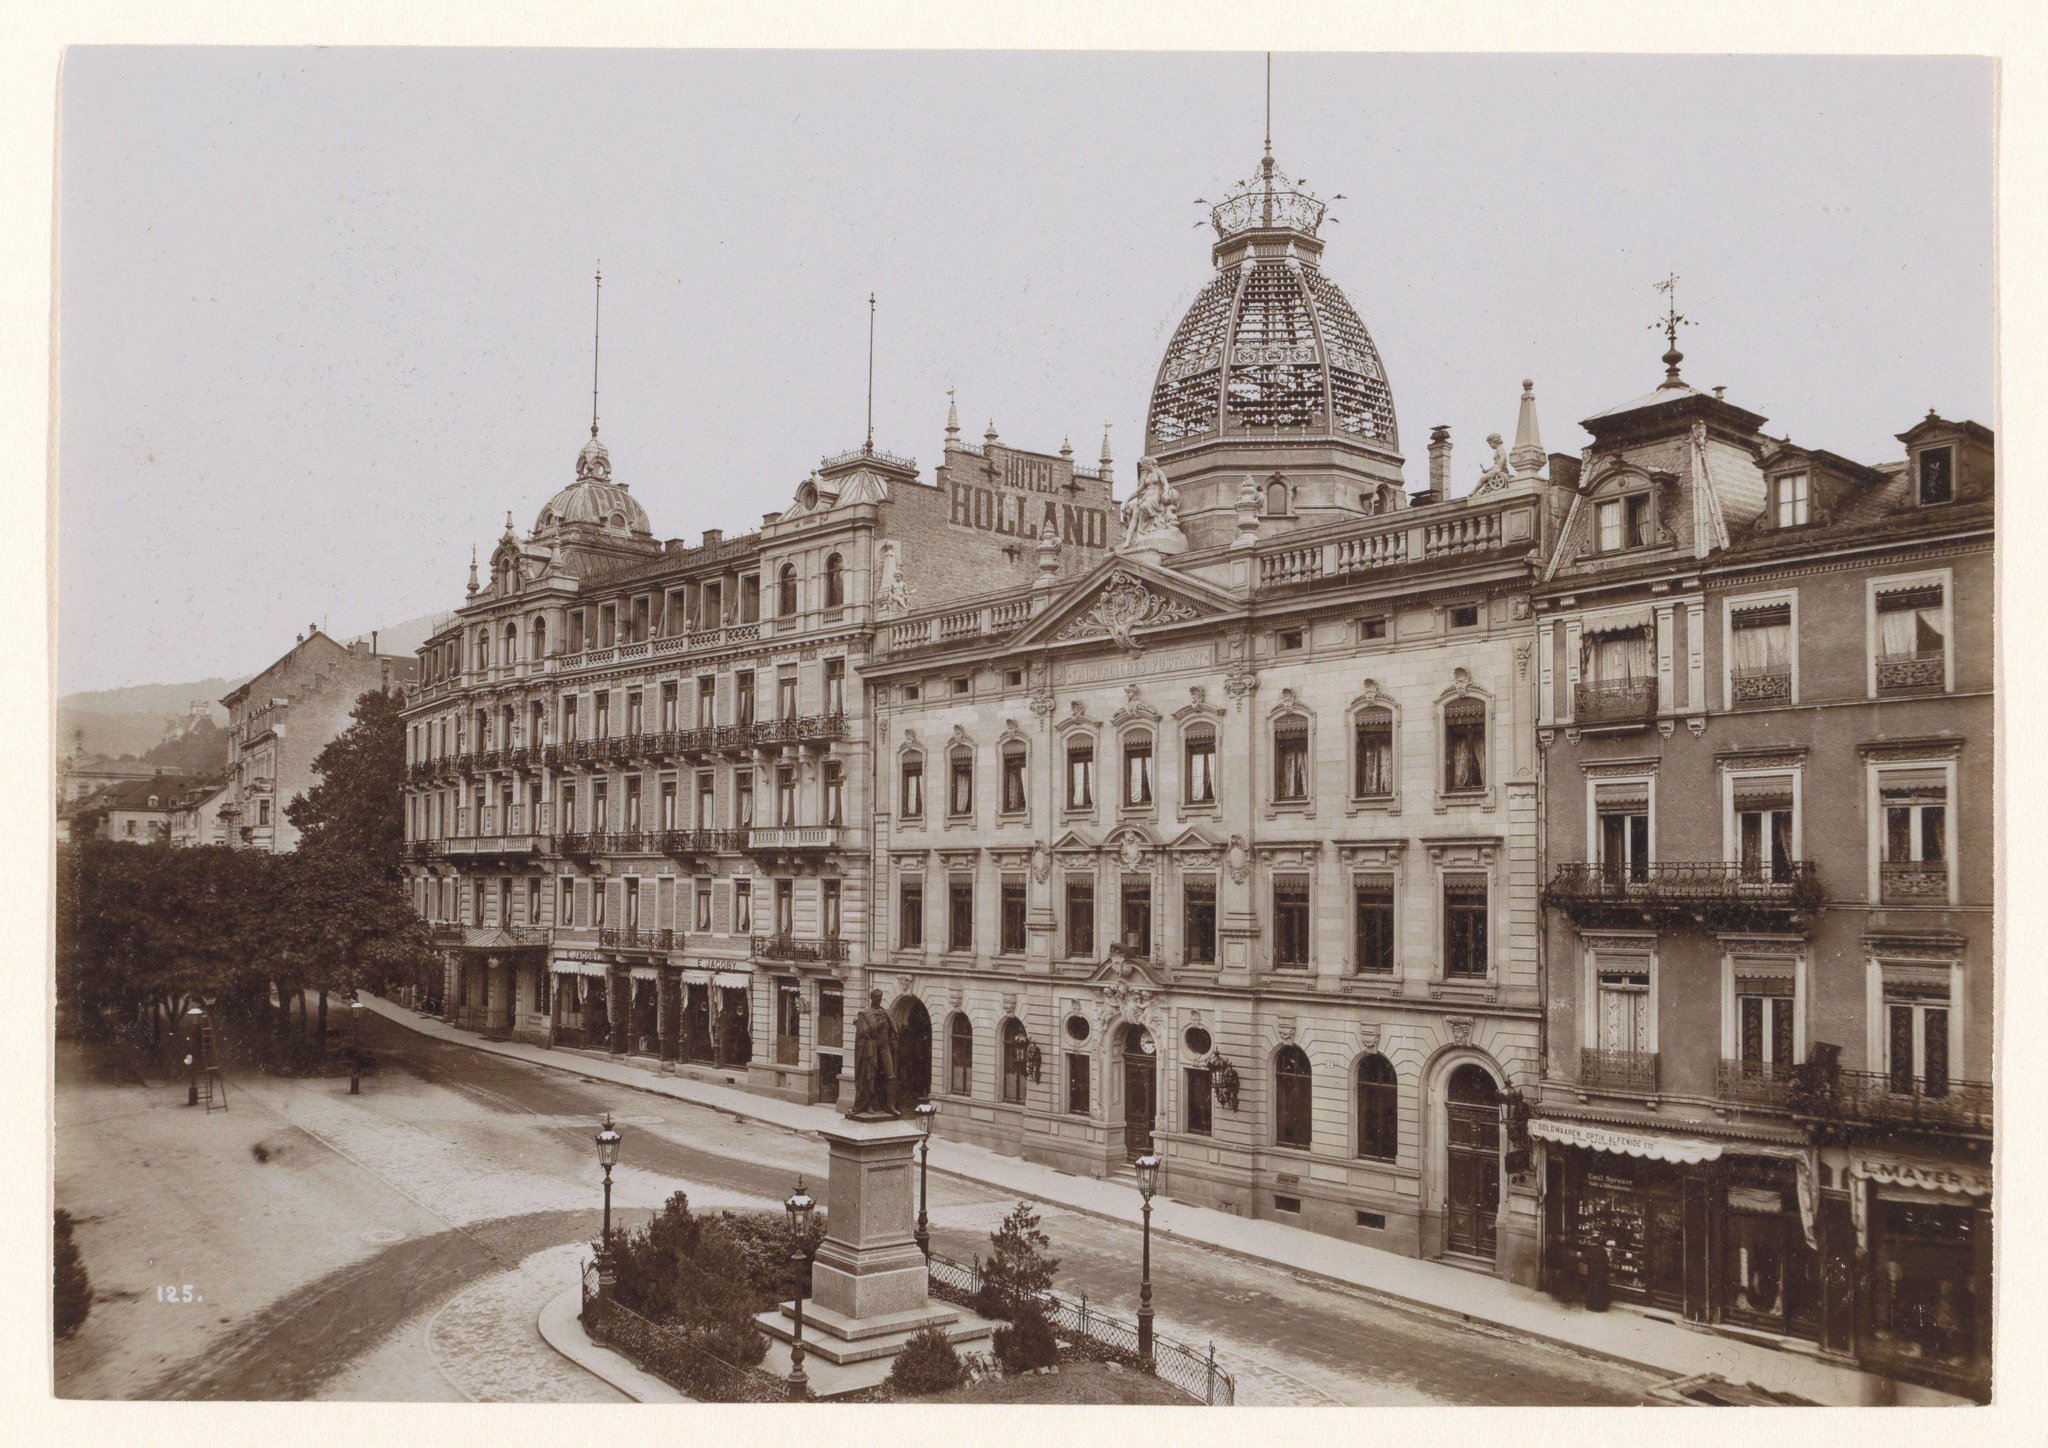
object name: photograph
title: Gezicht op de Leopoldsplatz in Baden-Baden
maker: gustav salzer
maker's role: fotograaf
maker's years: 1854-1910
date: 1903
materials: paper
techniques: collodion silver print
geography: baden-baden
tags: square, place, circus, etc., post-office, hotel, hostelry, inn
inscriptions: number: ‘125’, check stamp: ‘1903/ Gust. Salzer/ B. Baden’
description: In het midden het postkantoor ('Kaiserliches Postamt') en daarnaast Hotel Holland.